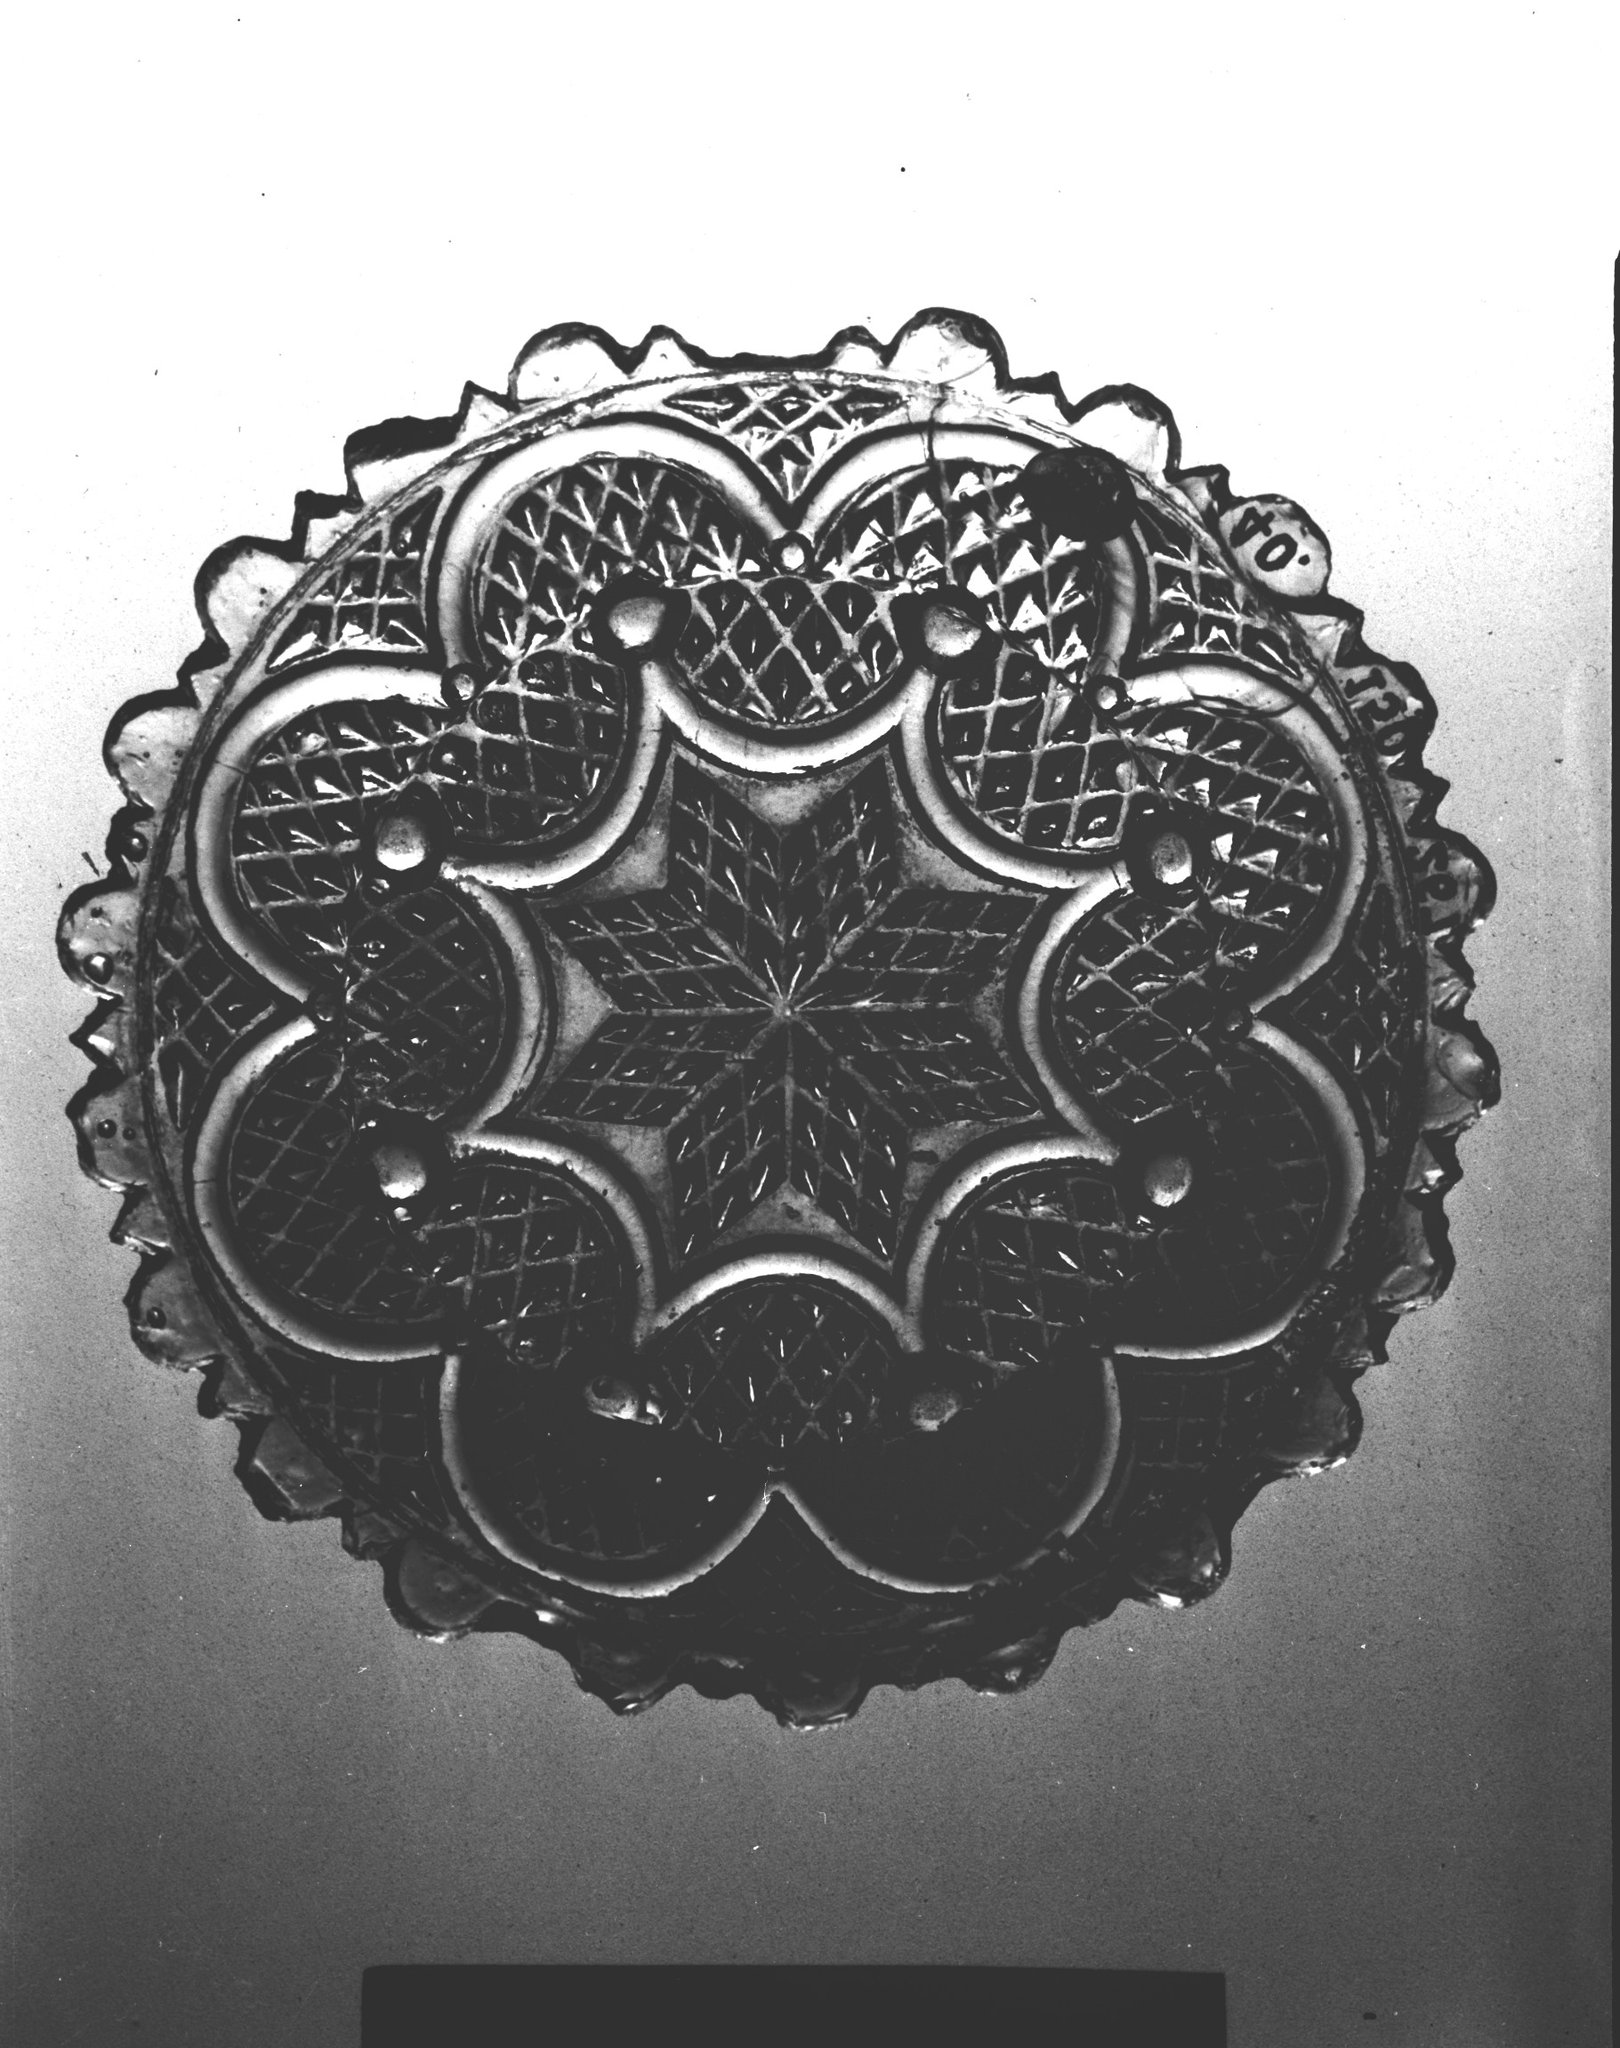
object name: cup plate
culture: american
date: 1830-1845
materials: glass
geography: united states